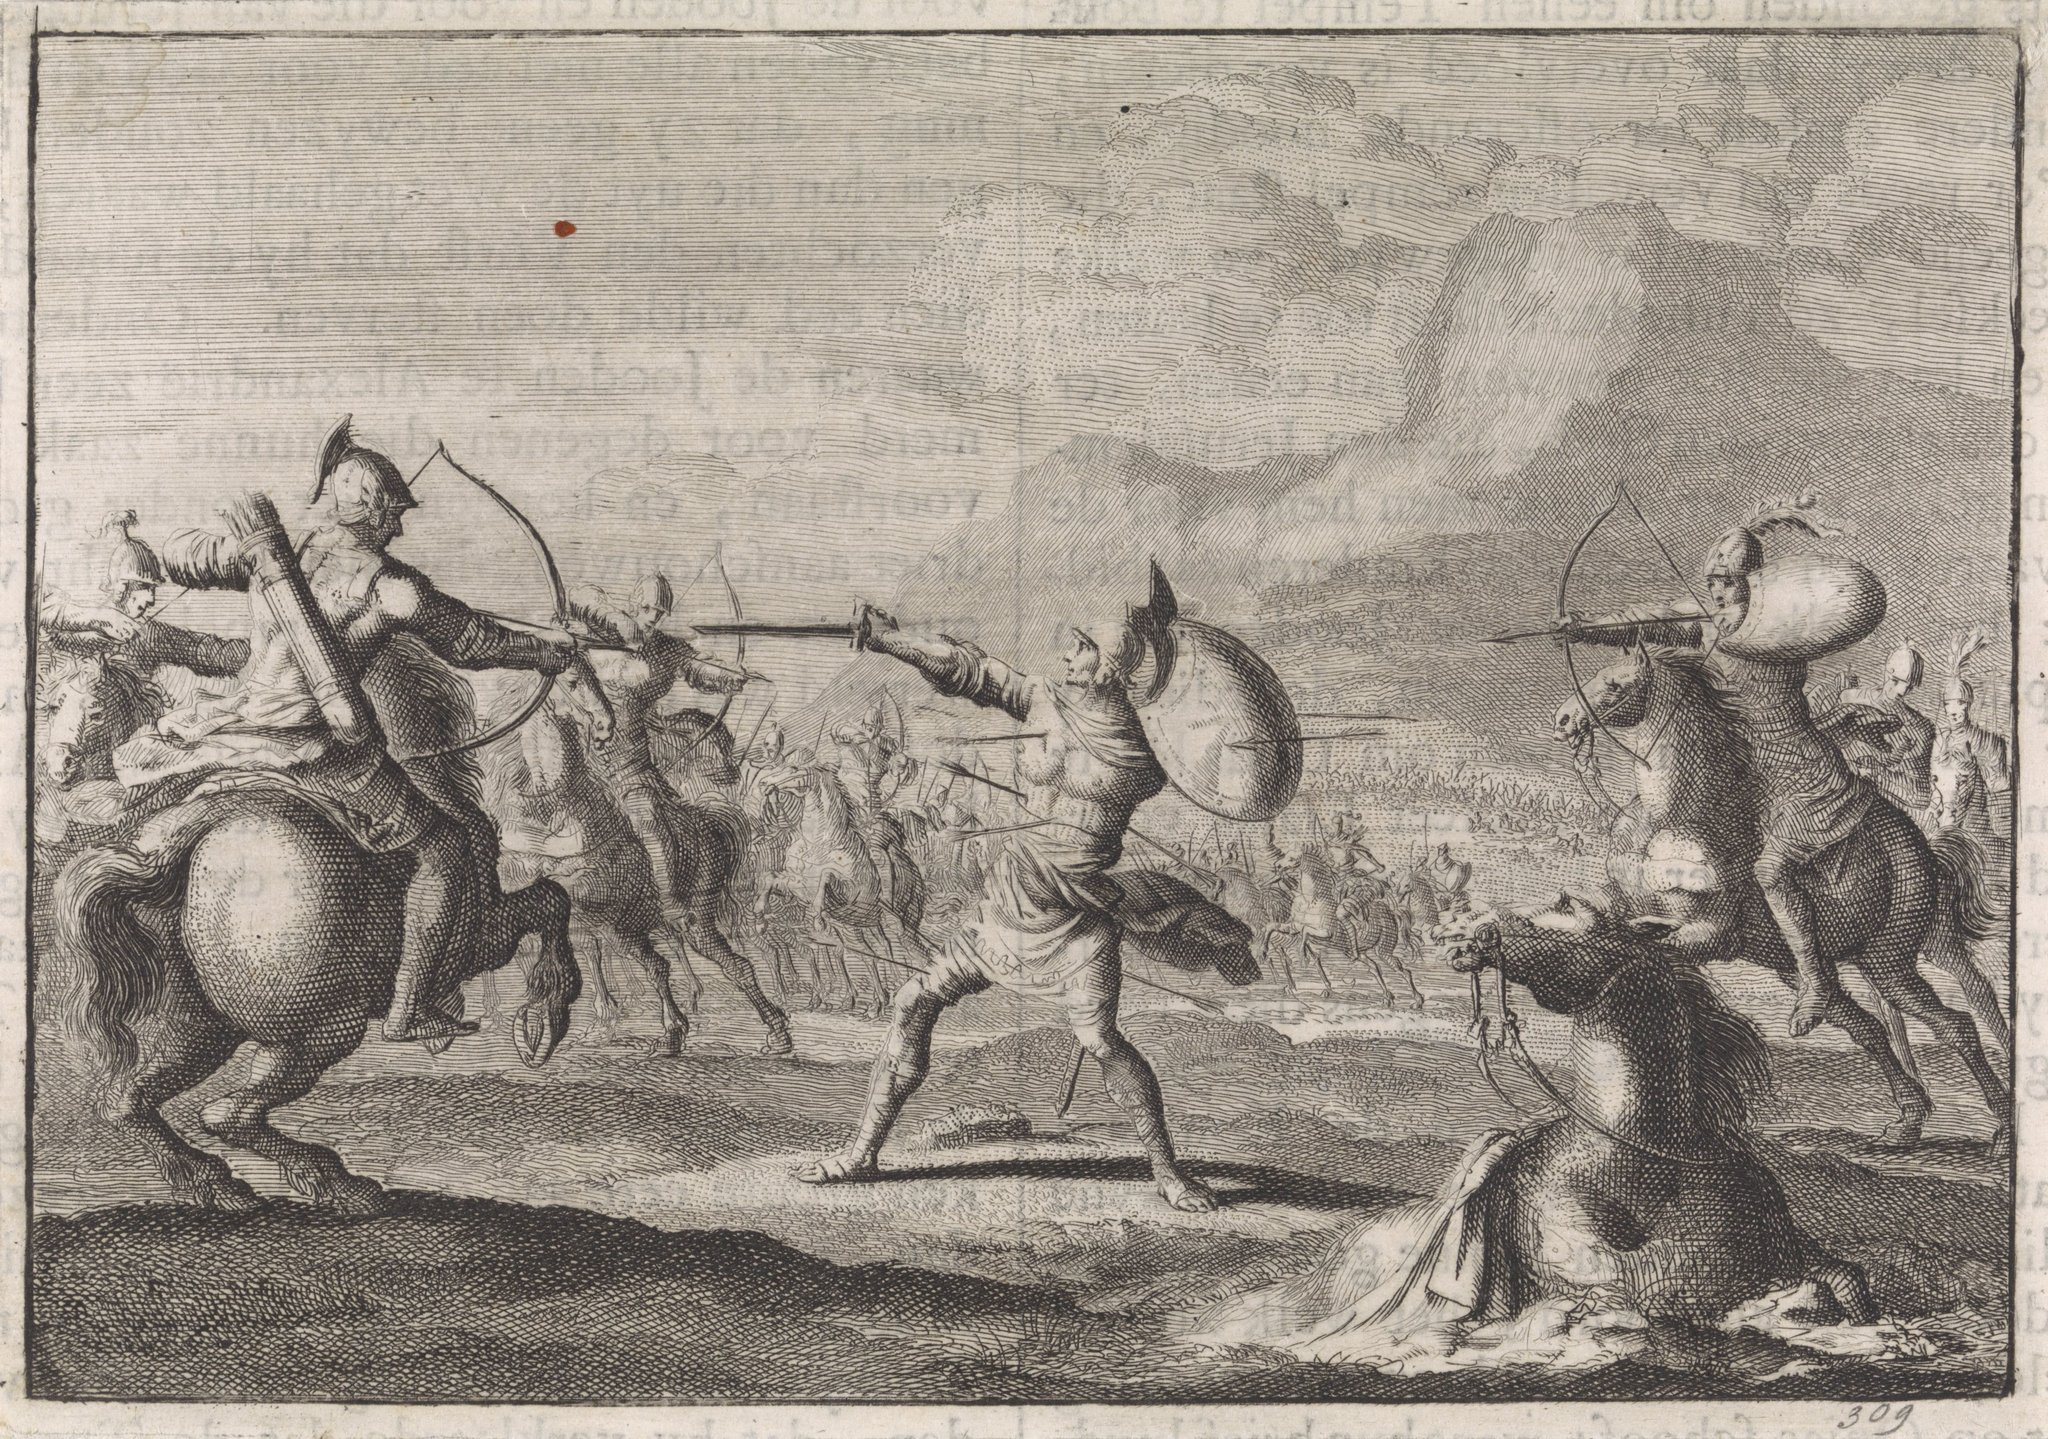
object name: print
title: Demetrius Seleucus verdedigt zich tegen schietende ruiters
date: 1704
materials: paper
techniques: etching, letterpress printing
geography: amsterdam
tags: battle of the maccabees against demetrius ii nikator of syria in the valley of asor (1 maccabees 11:67-74)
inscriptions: collector's mark: Lugt 2228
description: Prent opgenomen in: Josephus, Flavius. Alle de Werken, 2 delen. Amsterdam: Pieter Mortier, 1704, dl. 1, p. 309.